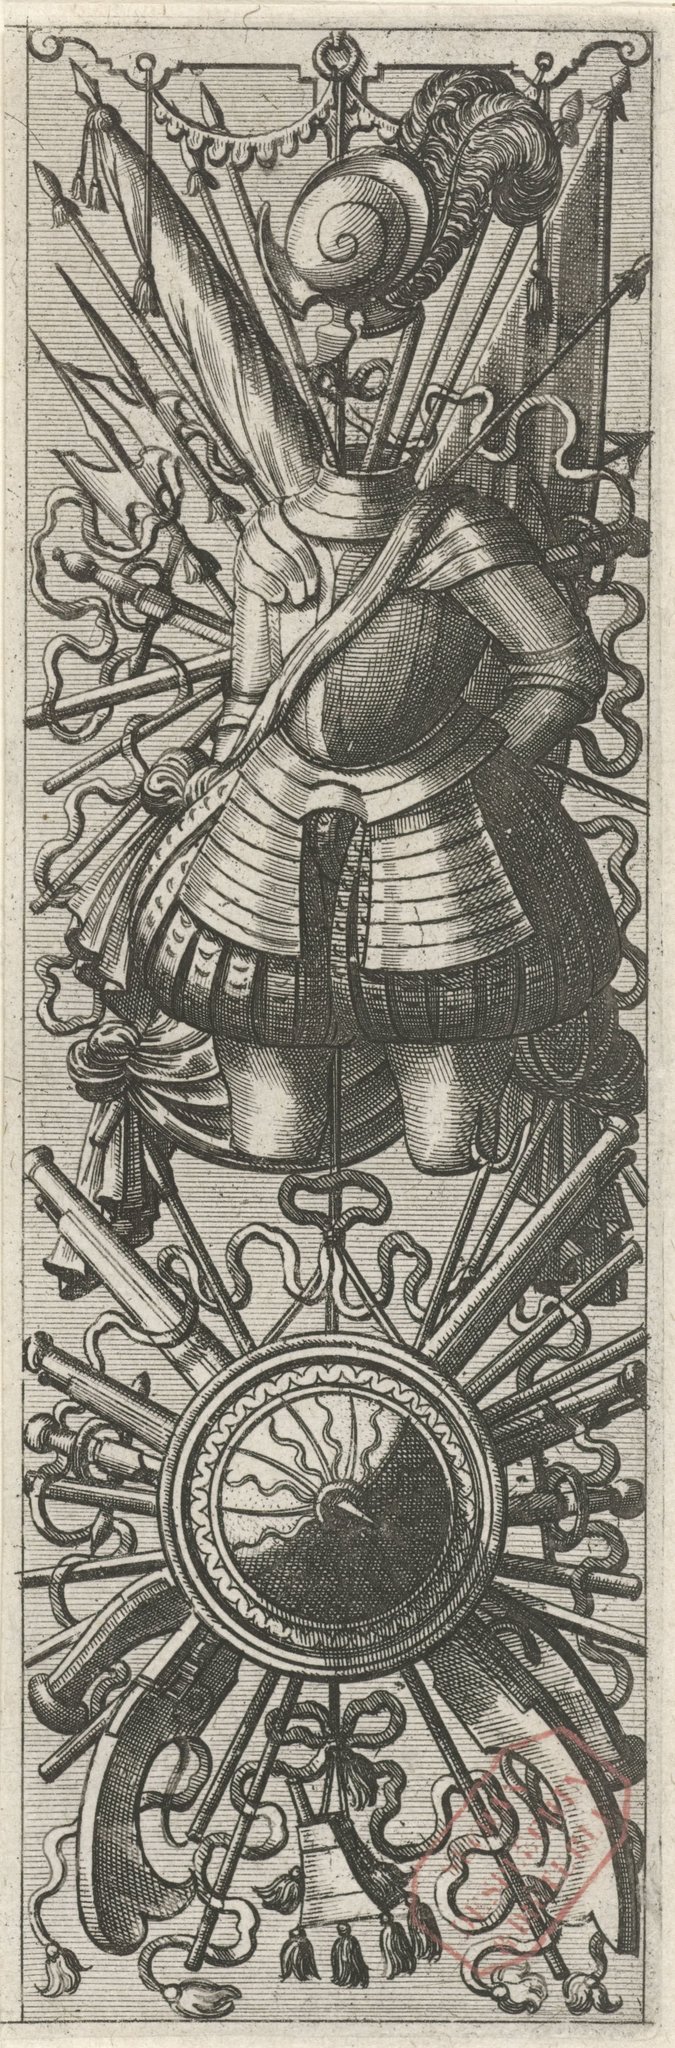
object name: print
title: Vlakdecoraties en friezen met trofeeën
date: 1572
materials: paper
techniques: etching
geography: netherlands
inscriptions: collector's mark: Lugt 2275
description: Trofee met gekruiste karabijnen en een schild. Uit serie, bestaande uit een titelblad en 16 bladen.